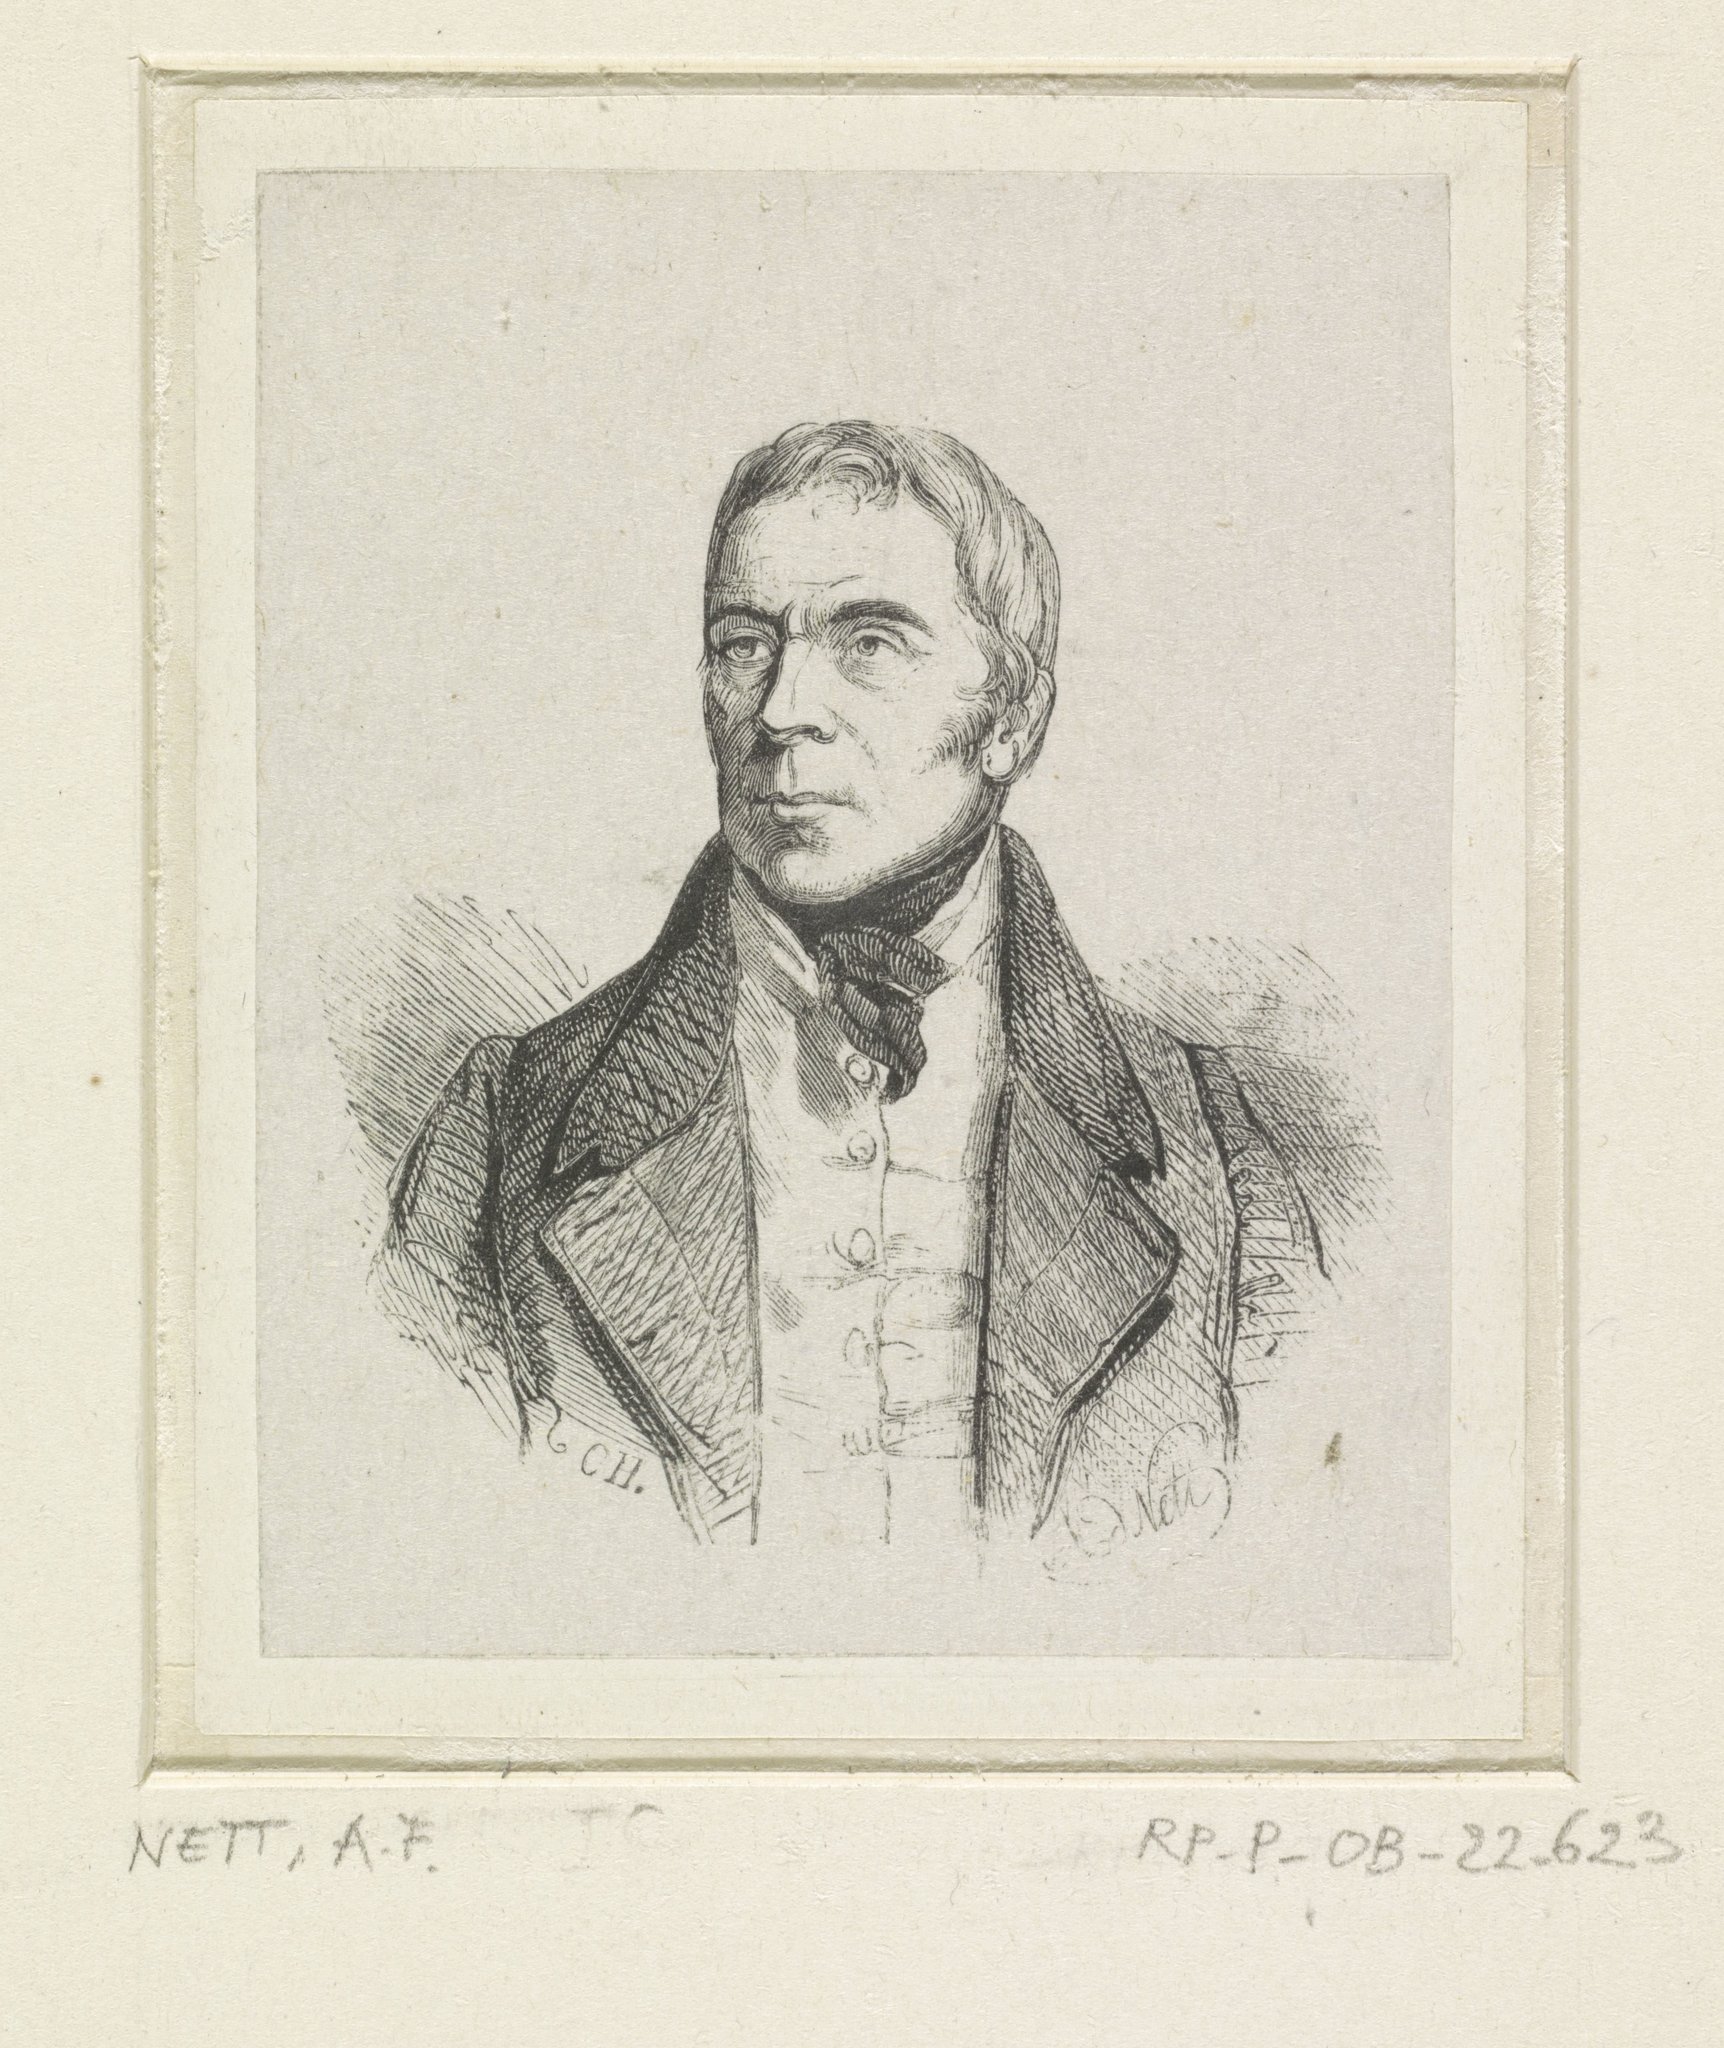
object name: print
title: Portret van Leendert de Koningh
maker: adolphe frédéric nett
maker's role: print maker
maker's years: 1822-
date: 1832-1900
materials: paper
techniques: engraving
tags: dordrecht, print maker, draughtsman, leendert de koningh, historical persons, portrait, self-portrait of artist